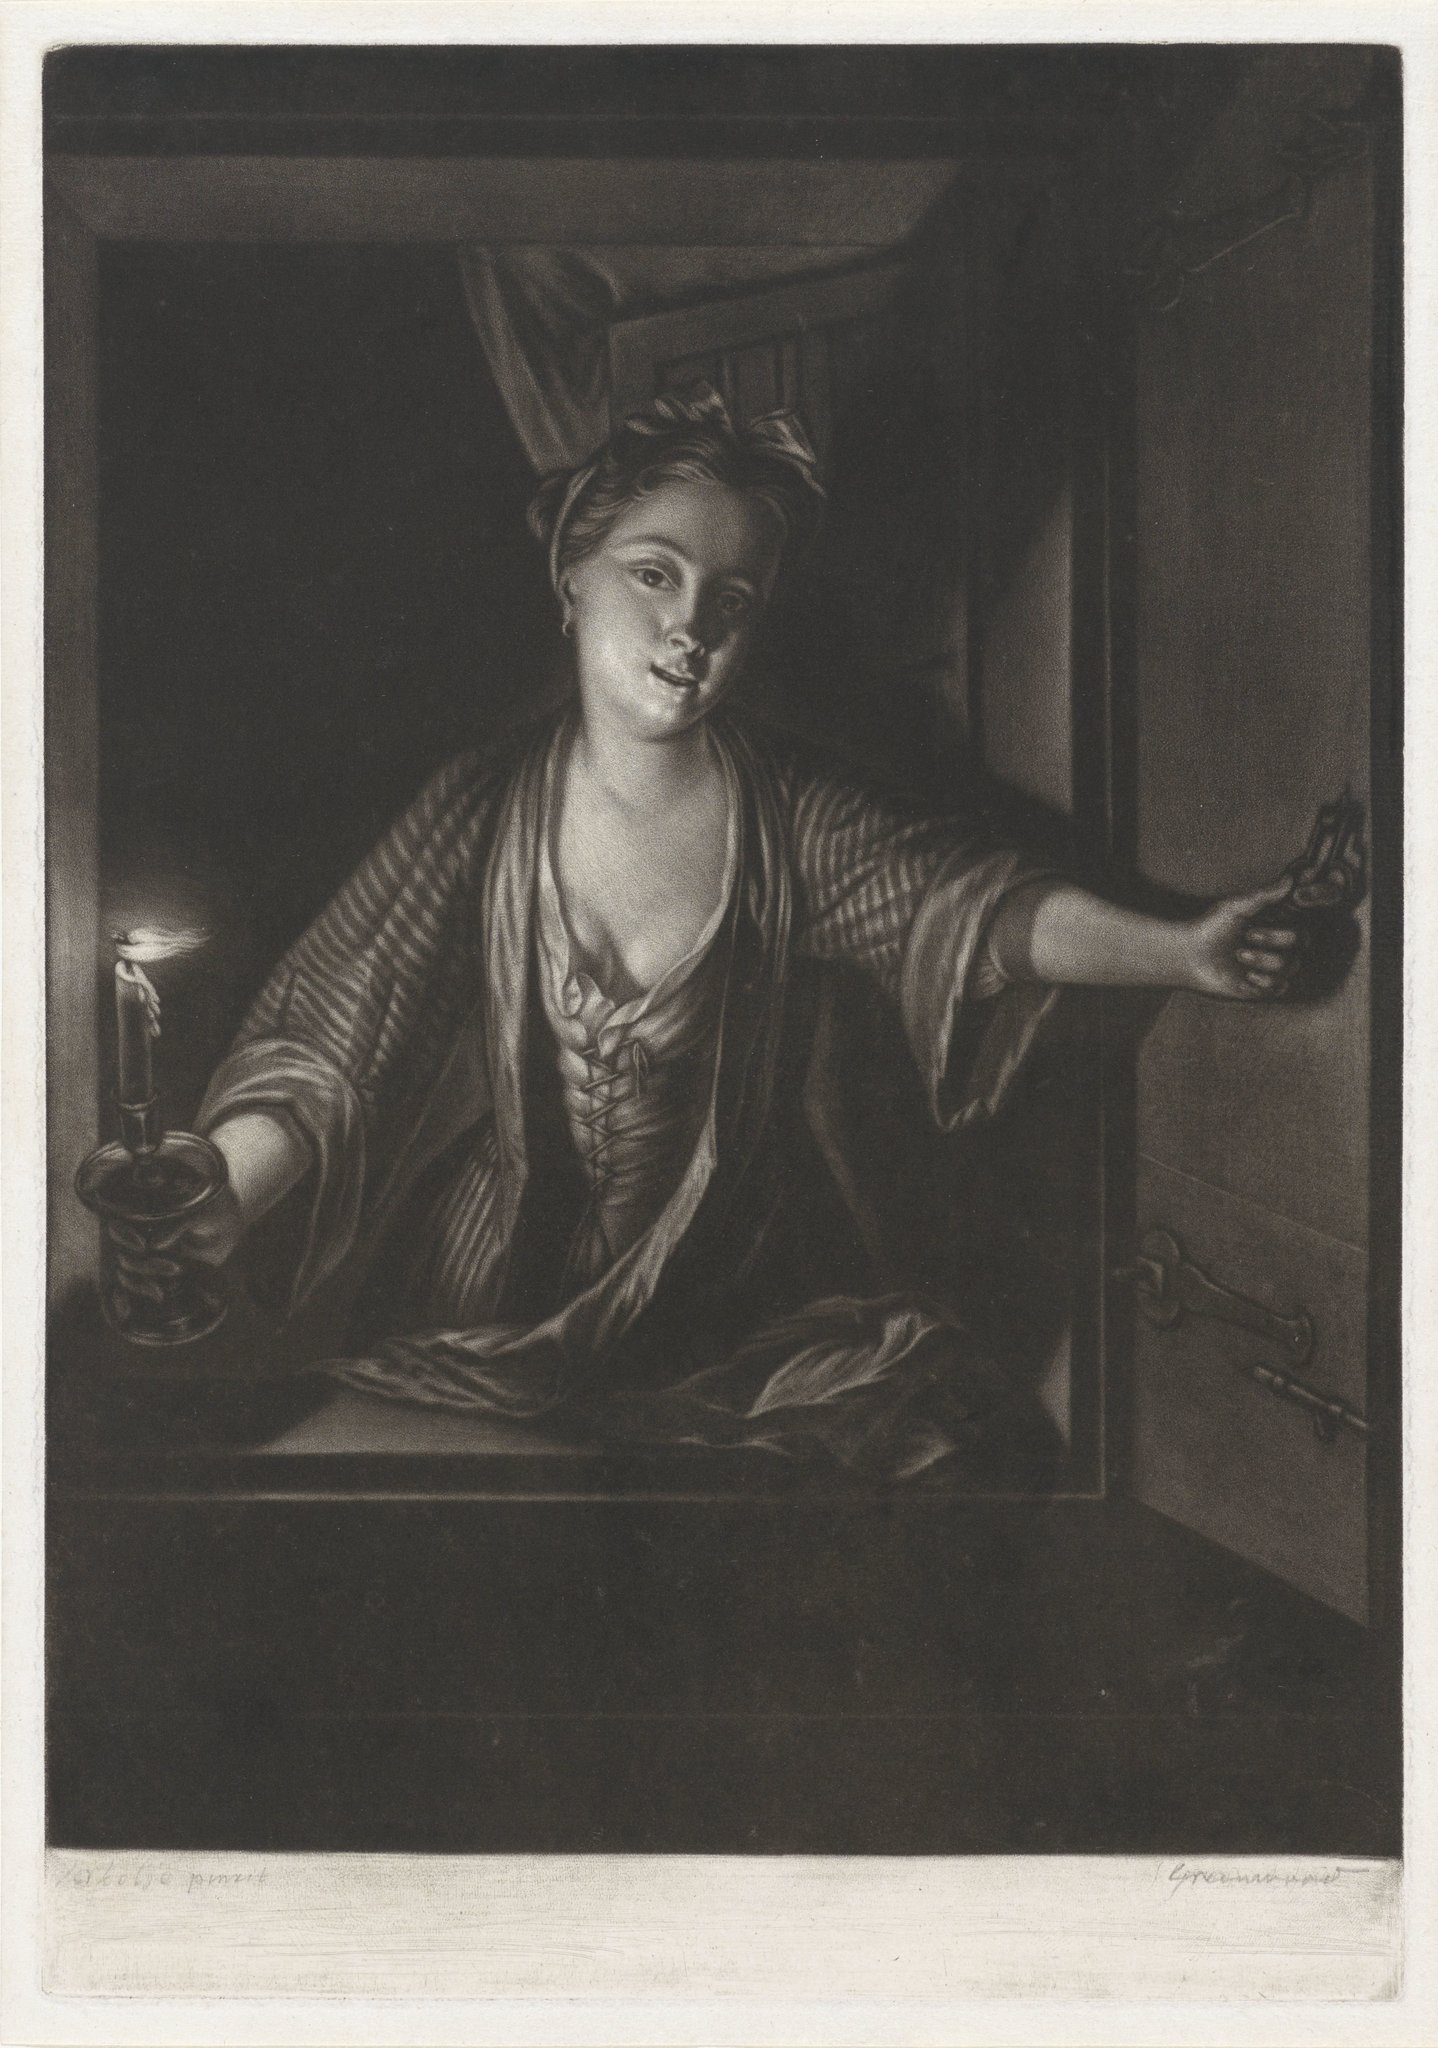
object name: print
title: Meisje met blaker bij een open raam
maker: john greenwood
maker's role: auctioneer, draughtsman, print maker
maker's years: 1727-1792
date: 1758-1763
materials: paper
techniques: mezzotint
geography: amsterdam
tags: candle, open window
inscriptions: collector's mark: Lugt 240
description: Een jonge vrouw sluit een venster, bij nacht. In de ene hand heeft ze een kaars en met de andere houdt ze de sluiting van het raam vast.